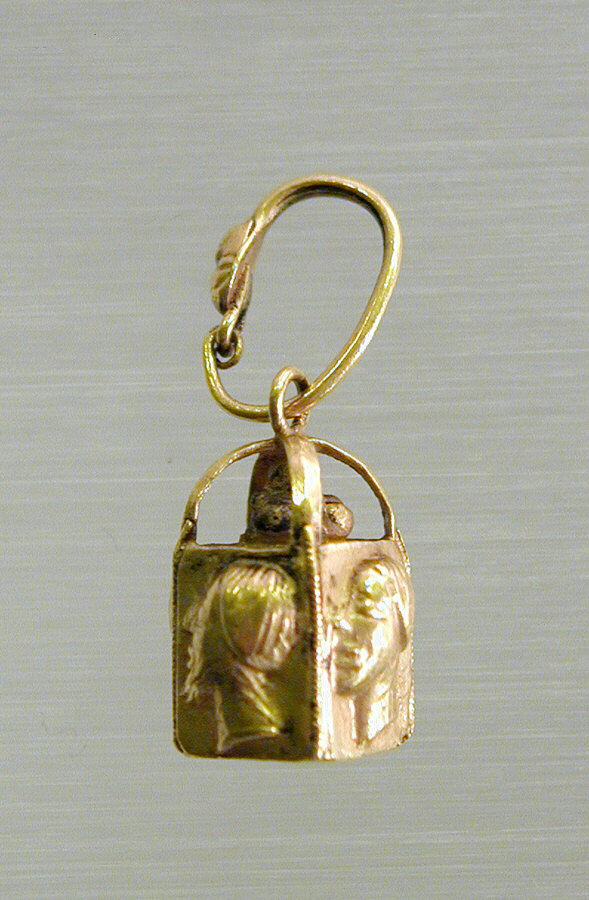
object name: earring with four relief face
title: Pair of gold earrings with four relief faces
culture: phoenician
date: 334-201 BCE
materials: gold